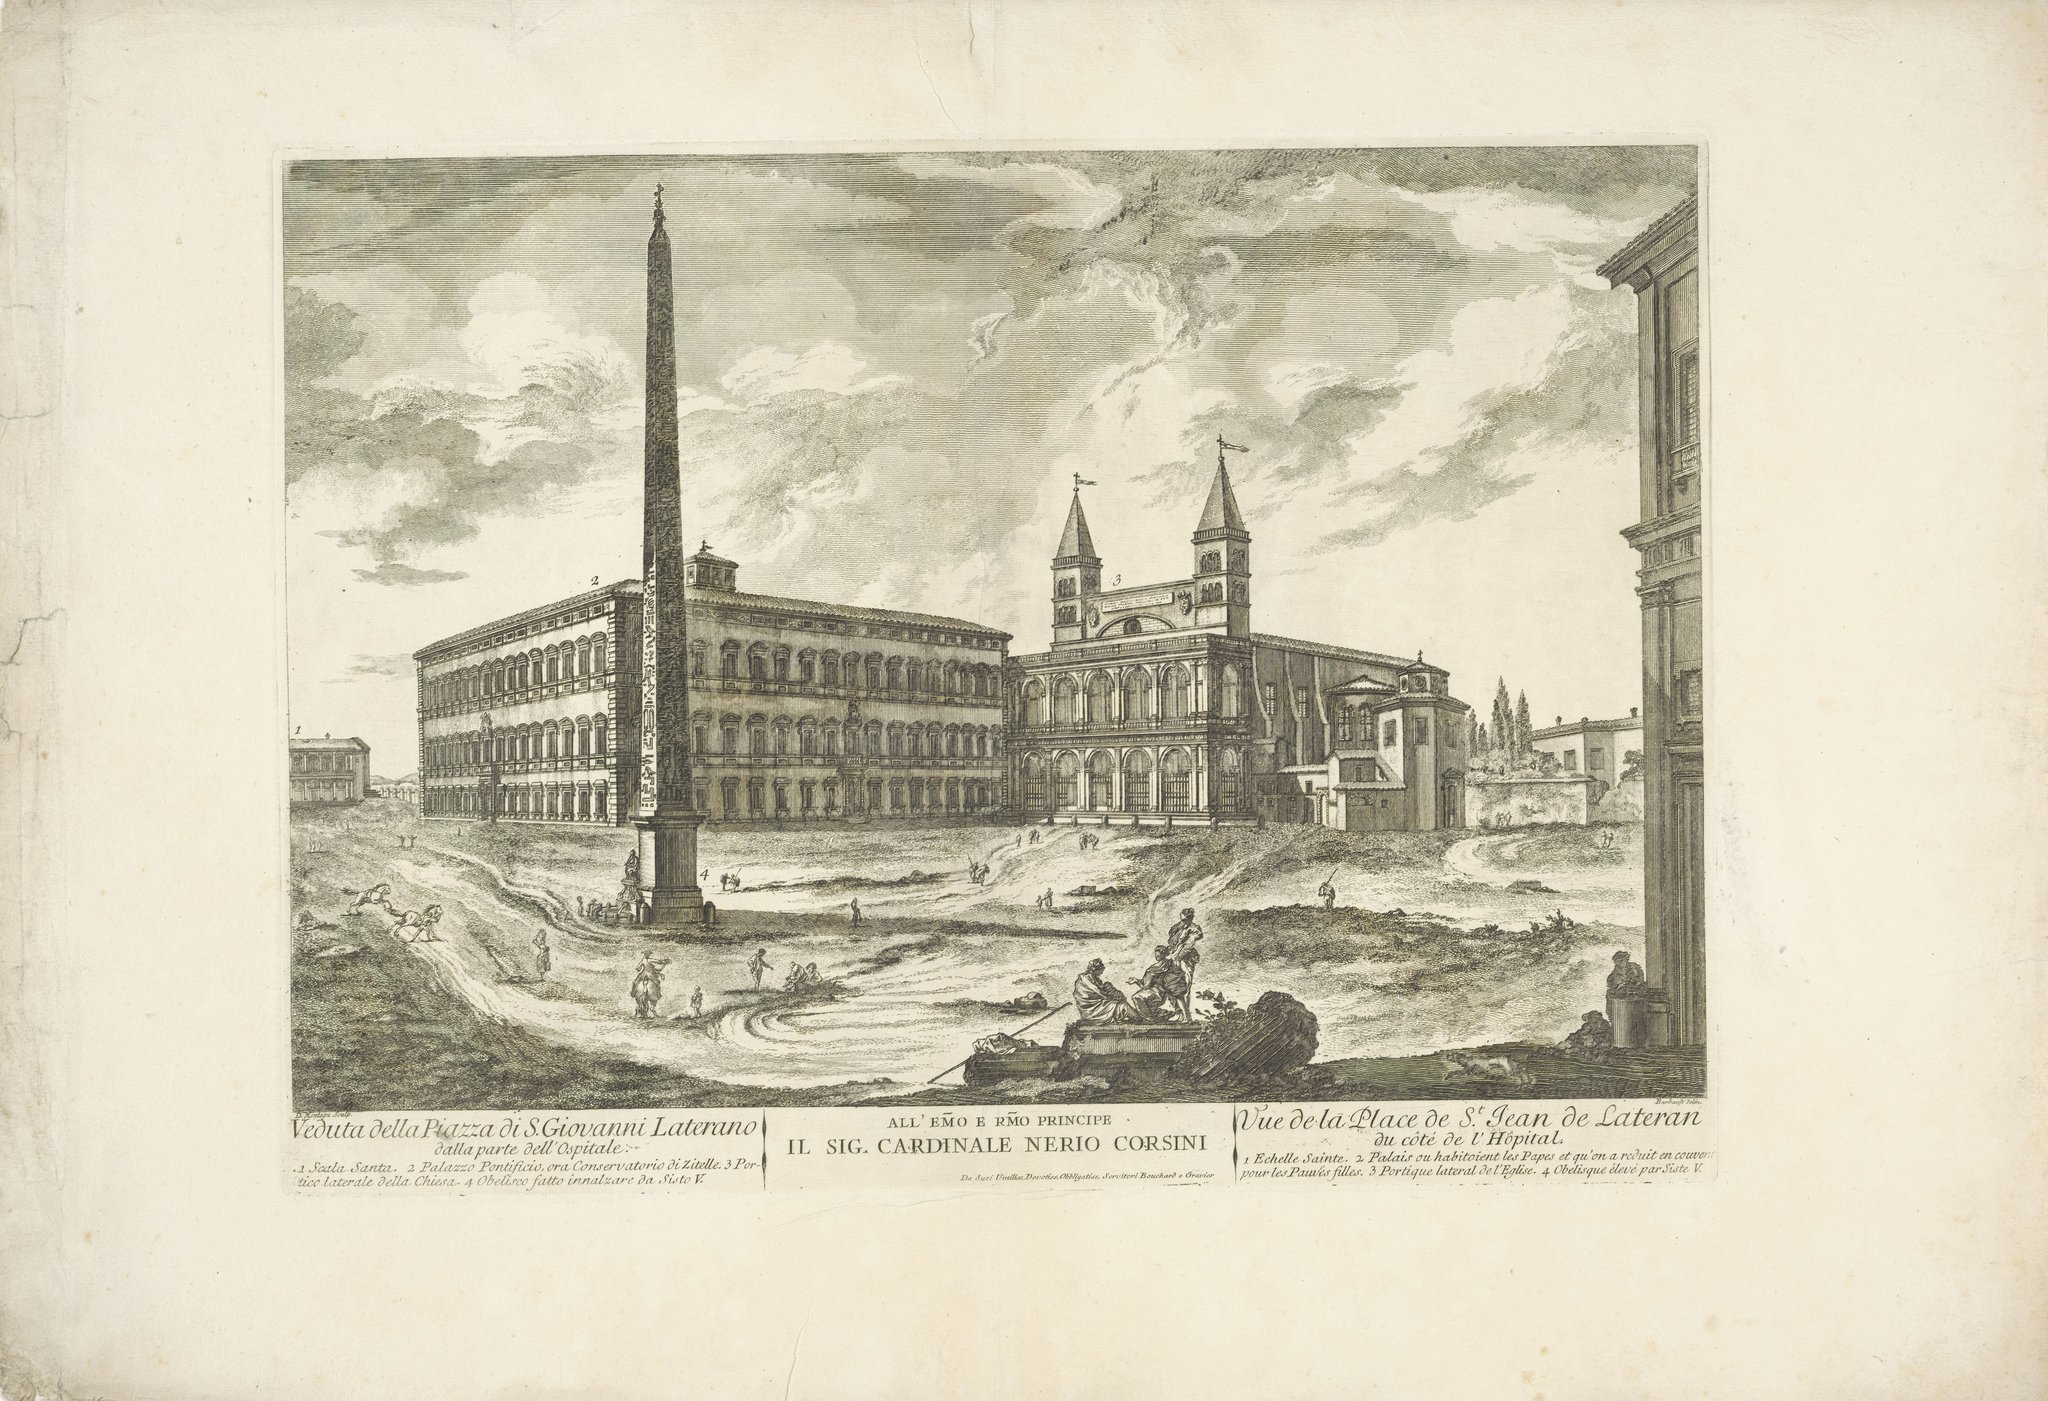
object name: print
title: Veduta della Piazza di S. Giovanni Laterano dalla parte dell'Ospitale / Vue de la Place de St. Jean de Lateran du côté de l'Hôpital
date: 1750-1799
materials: paper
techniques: etching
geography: italy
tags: city-view, and landscape with man-made constructions, obelisk, needle, palace, church (exterior), rome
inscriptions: collector's mark: Lugt 2228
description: Gezicht op het Lateraan te Rome met de Heilige Trap (Scala Sancta), de achterzijde van de basiliek van Sint-Jan van Lateranen, het Lateraans Paleis en de Lateraanse Obelisk. Titels en verklarende lijsten met nummers in het Frans en Italiaans en een opdracht in de ondermarge.